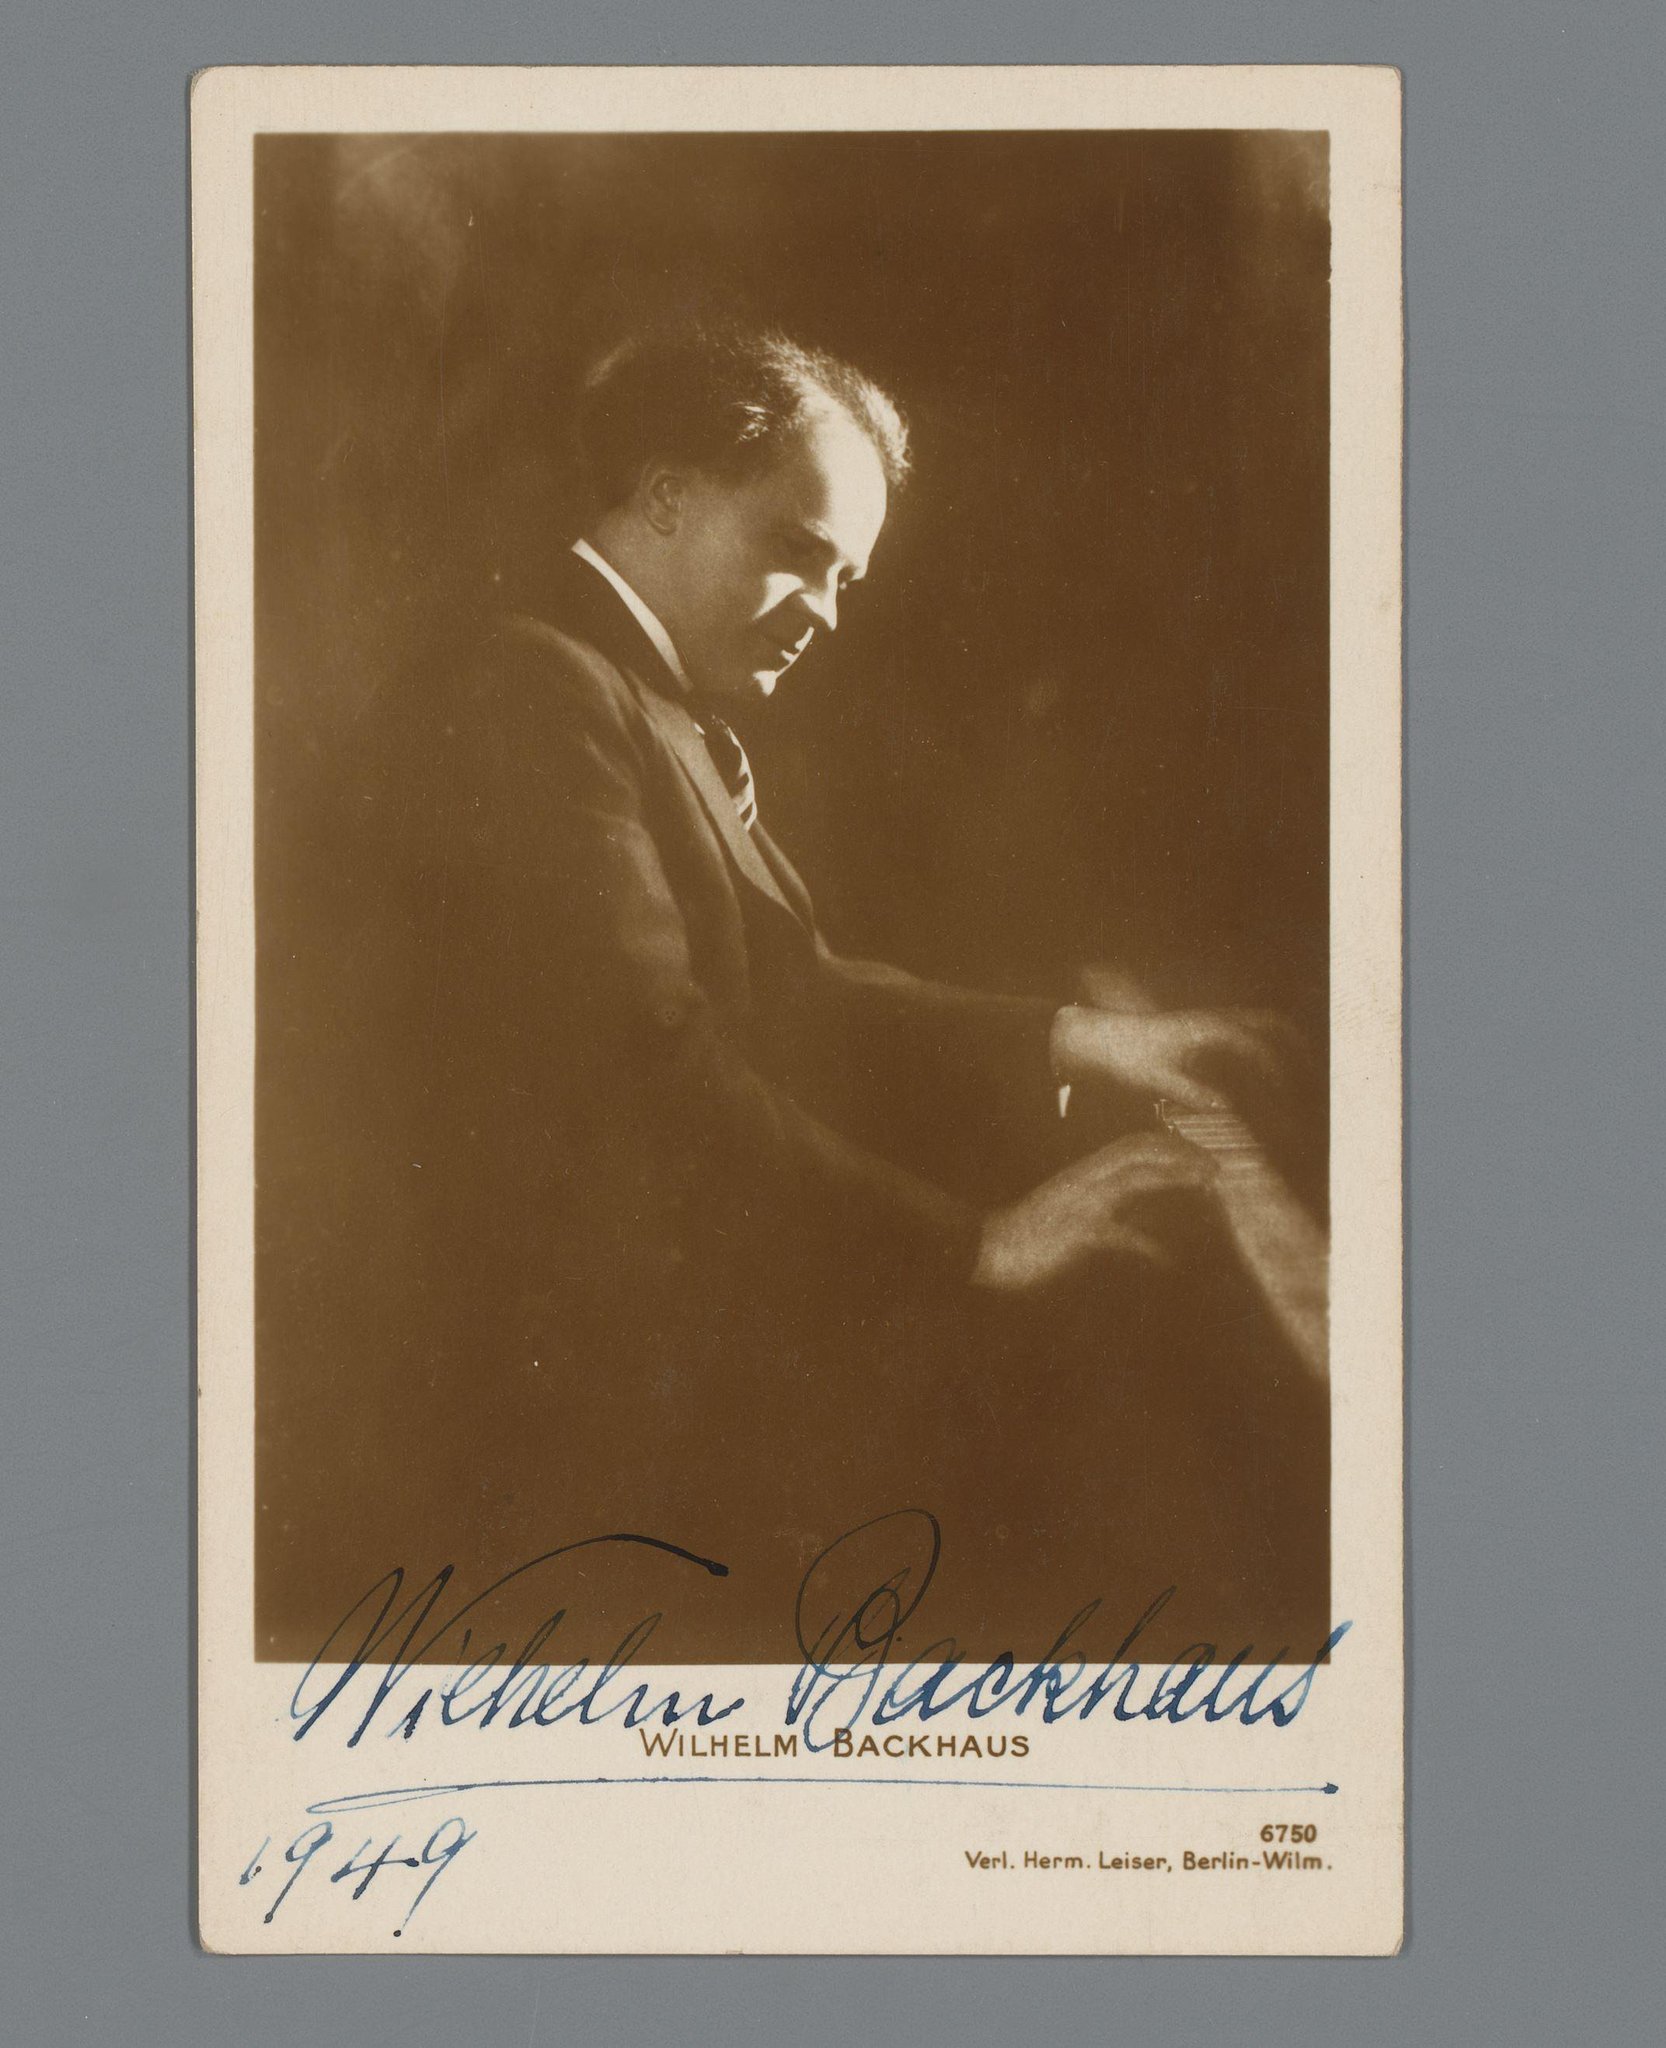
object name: photograph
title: Portret van de pianist Wilhelm Backhaus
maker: Anonymous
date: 1949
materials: paper, ink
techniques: gelatin silver print, pen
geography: berlin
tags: making music; musician with instrument, historical persons, berlin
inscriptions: inscription: ‘Wilhelm Backhaus/ 1949’, inscription: ‘Wilhelm Backhaus, pianist,/ (...) pupil of Eugen D'Albert.’